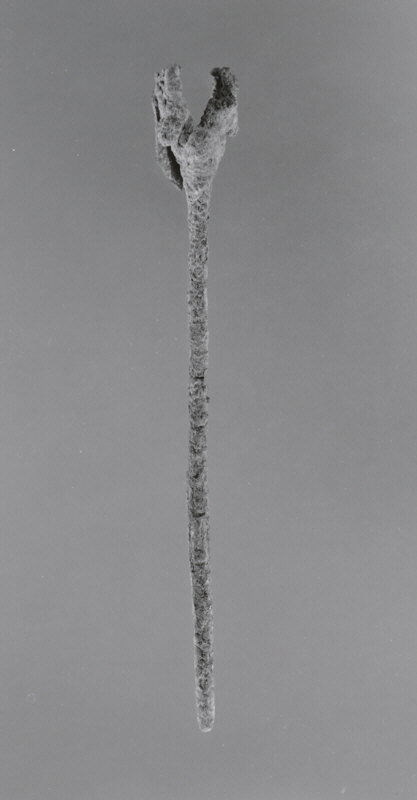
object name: pin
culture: bactria-margiana archaeological complex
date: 2333-1668 BCE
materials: copper alloy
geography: bactria-margiana